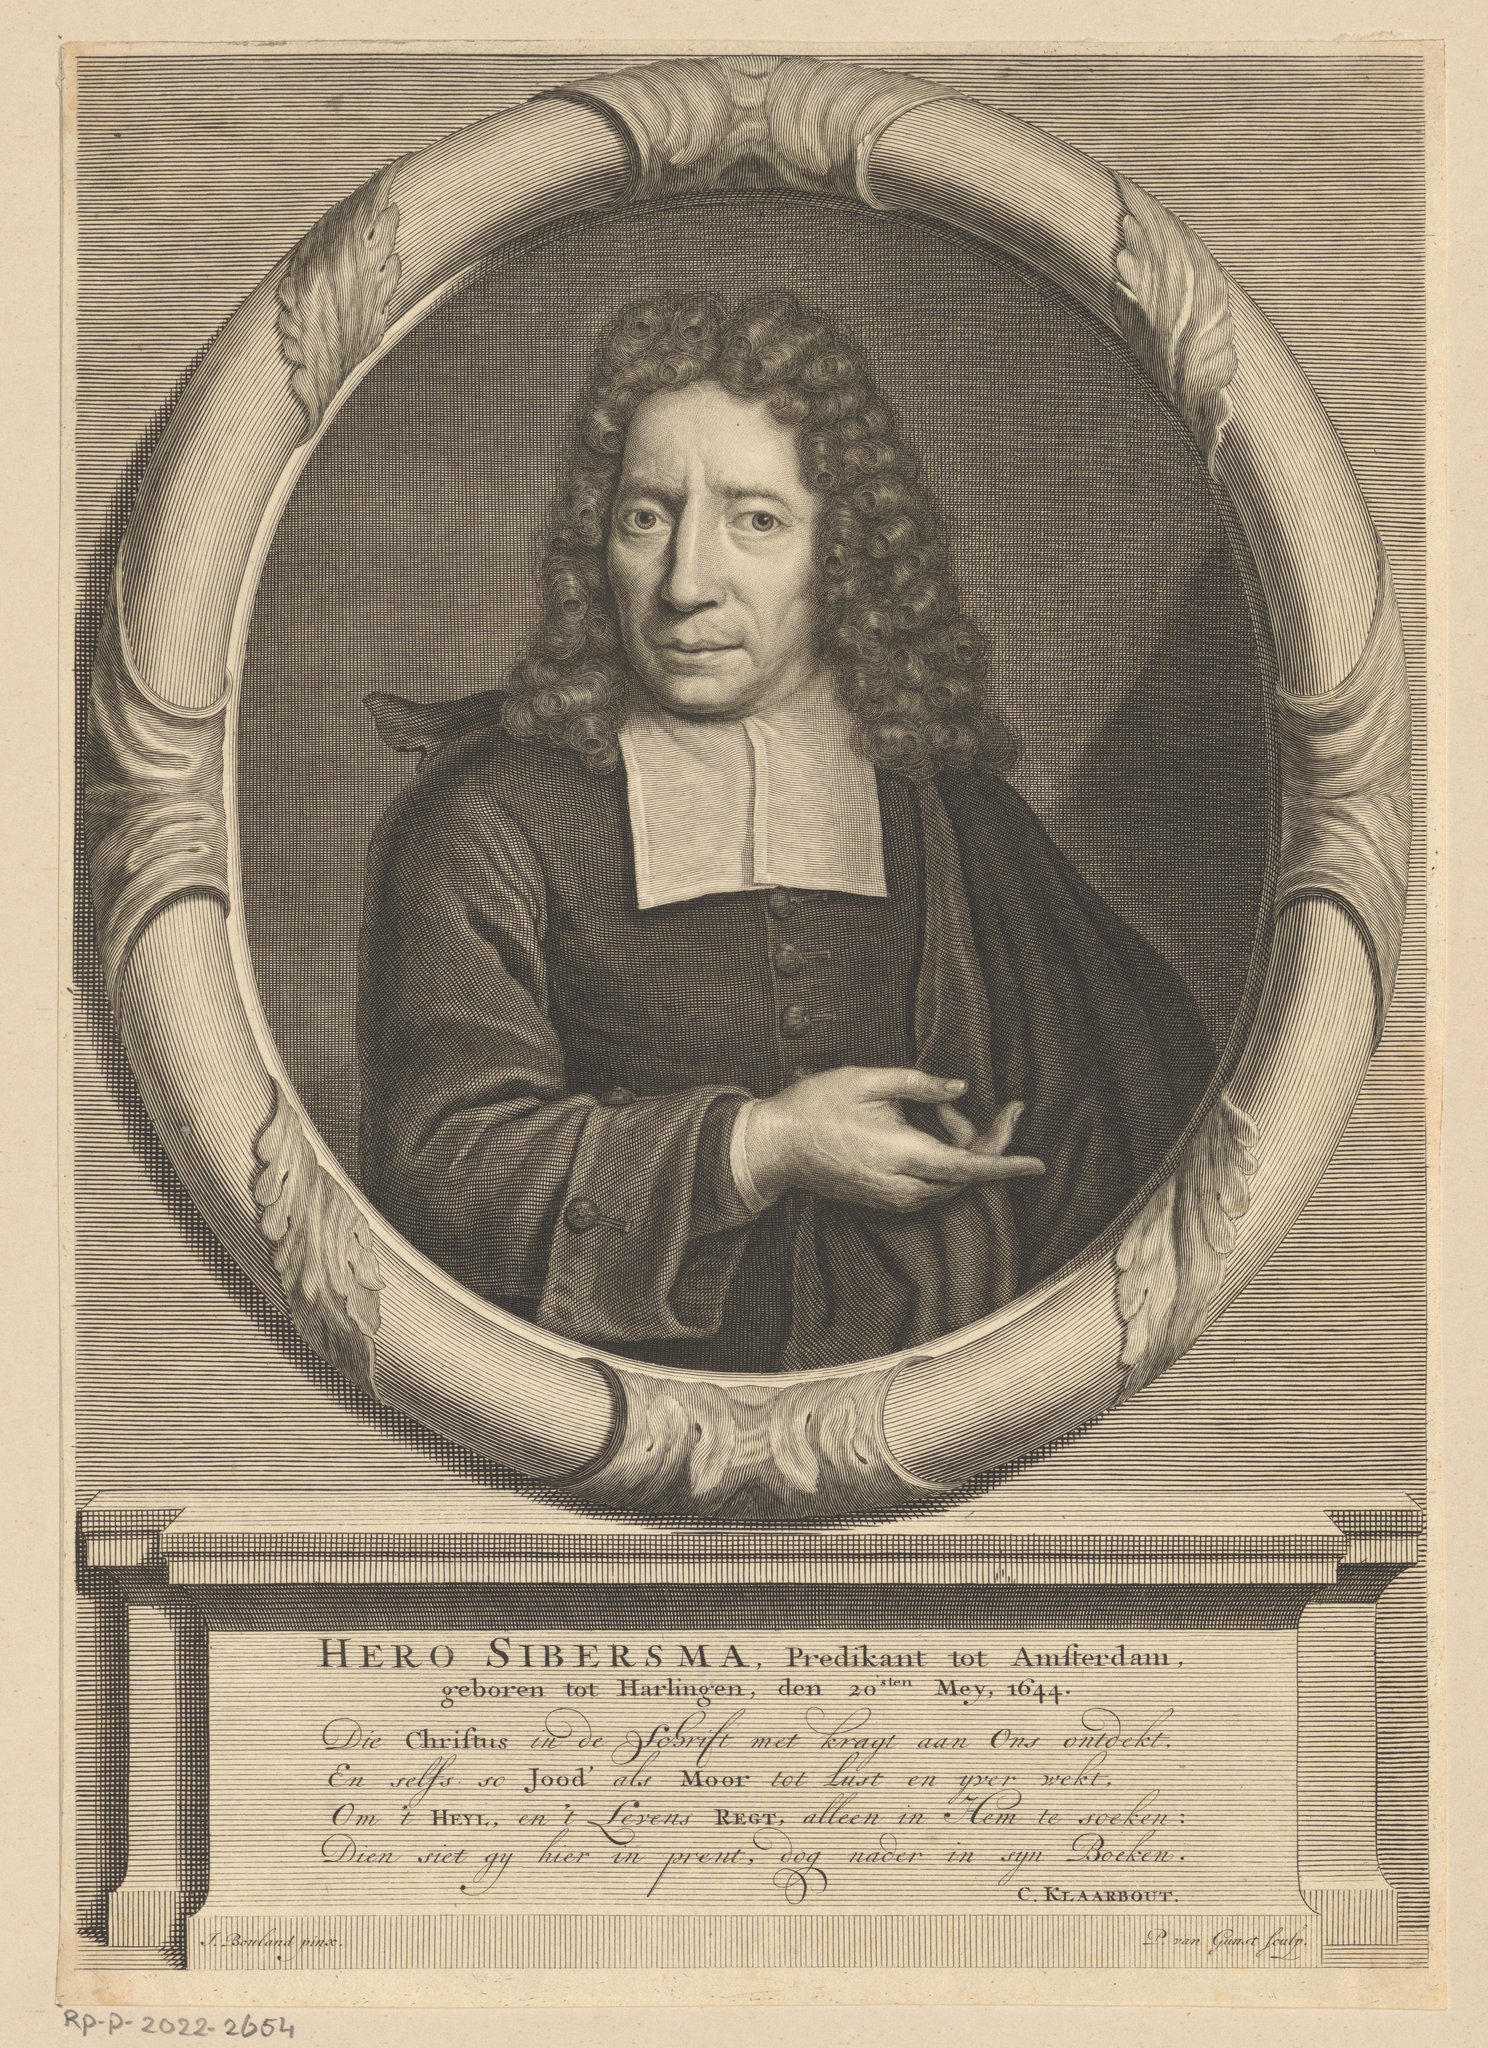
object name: print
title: Portret van Hero Sibersma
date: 1674-1731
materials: paper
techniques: engraving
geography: amsterdam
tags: amsterdam, functionaries and dignitaries (with name) ~ episcopal protestant churches, historical persons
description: Met zesregelig onderschrift in het Nederlands.